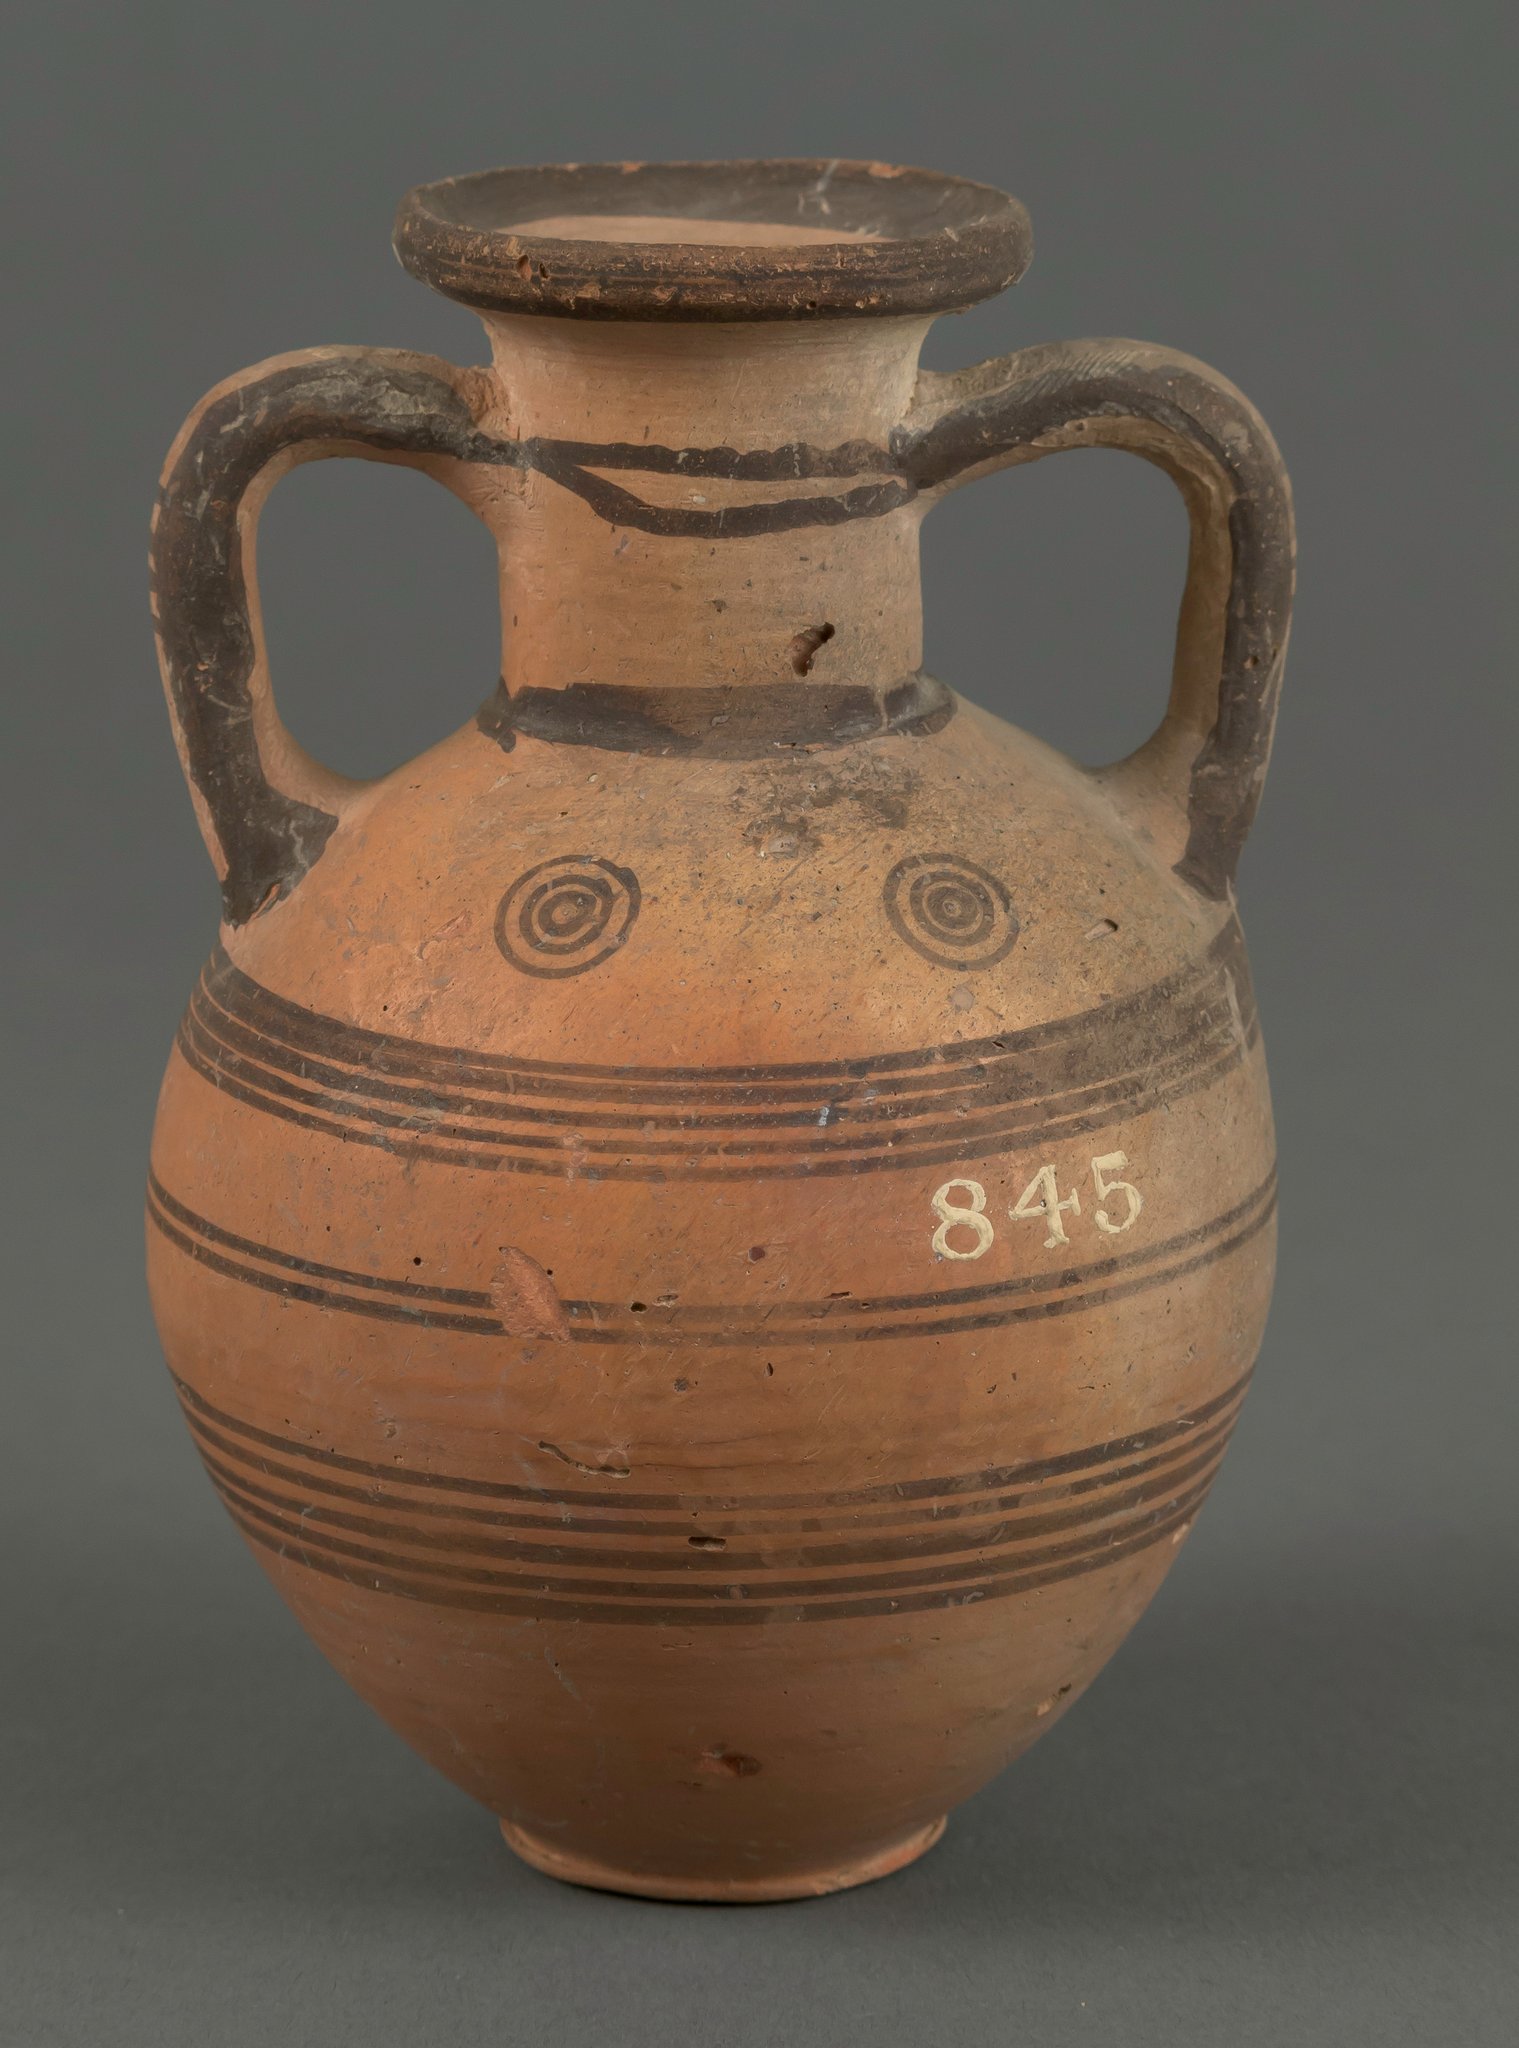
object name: amphora, miniature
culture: cypriot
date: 750-600 BCE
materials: terracotta